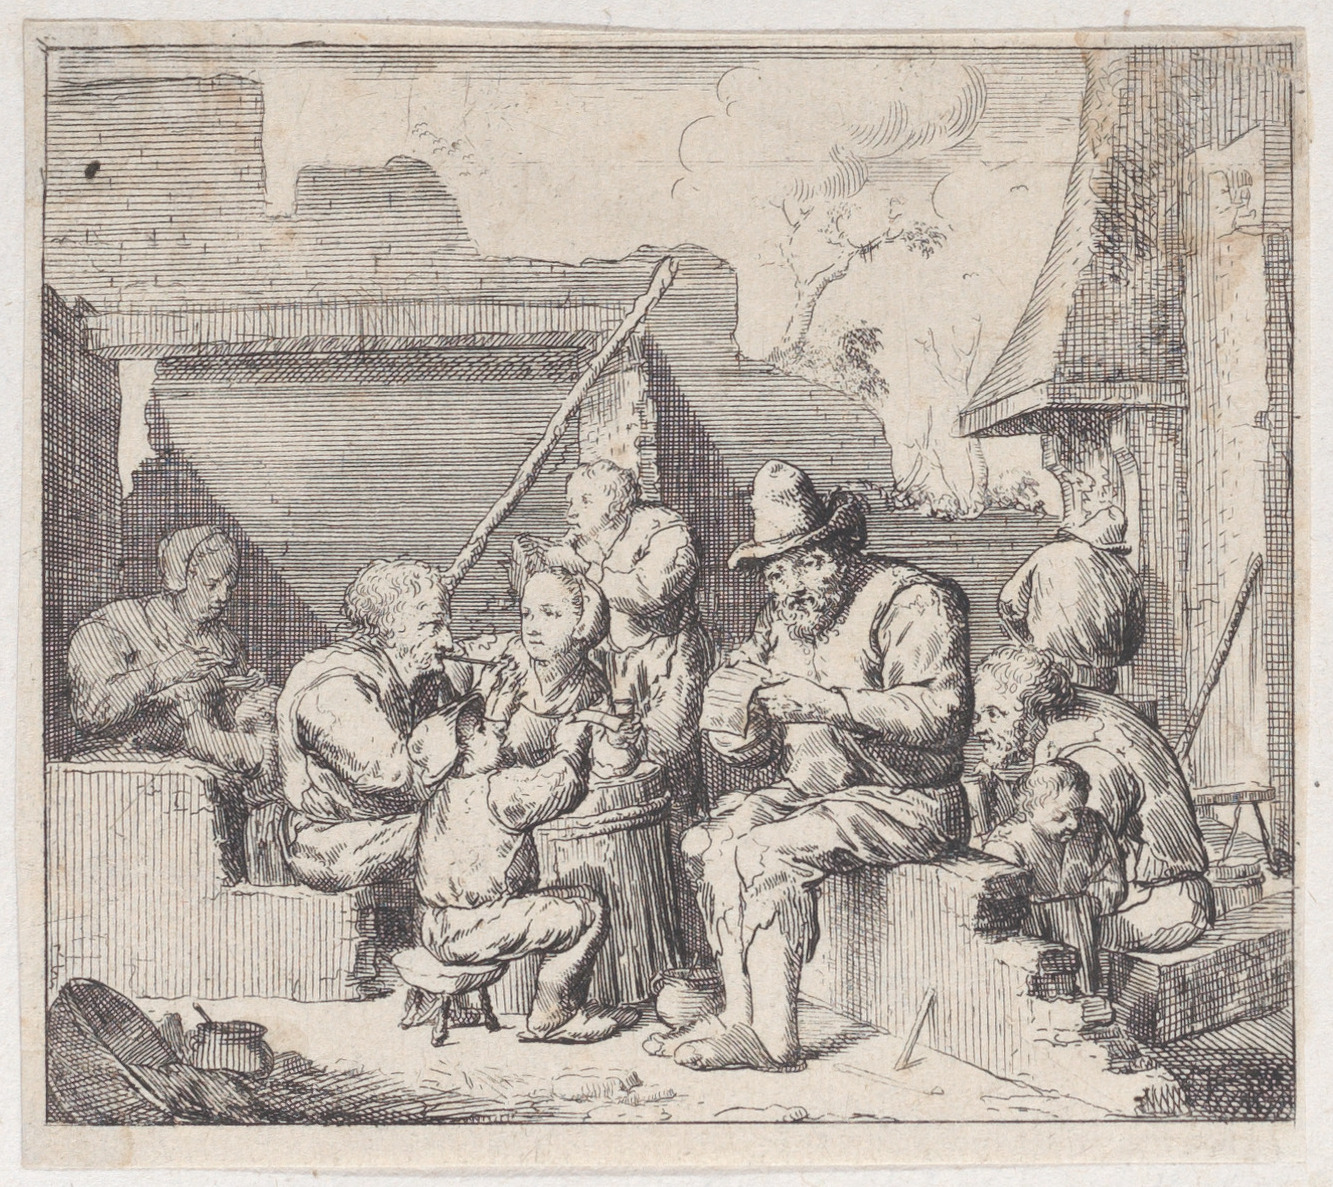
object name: print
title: Ten peasants in a ruined house with a seated man at center reading a paper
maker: jacques dassonville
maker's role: artist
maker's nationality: french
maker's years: 1614-1675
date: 1640-1670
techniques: etching